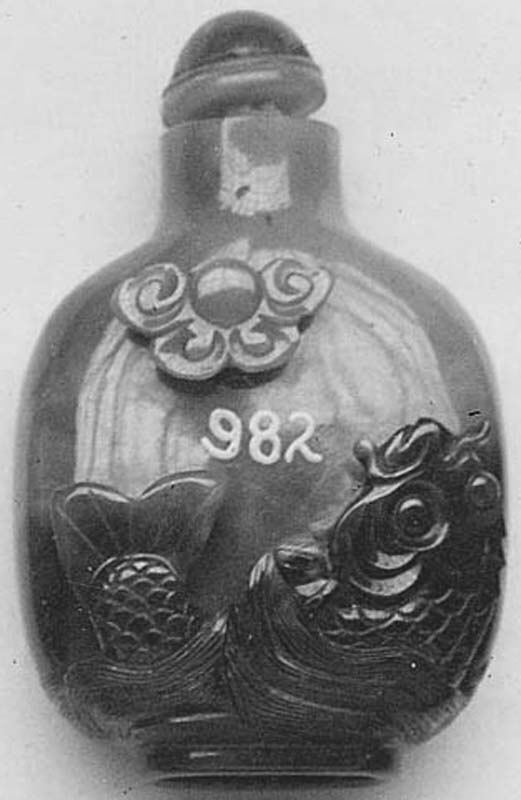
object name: snuff bottle with stopper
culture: chinese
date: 1701-1900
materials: stone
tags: fish